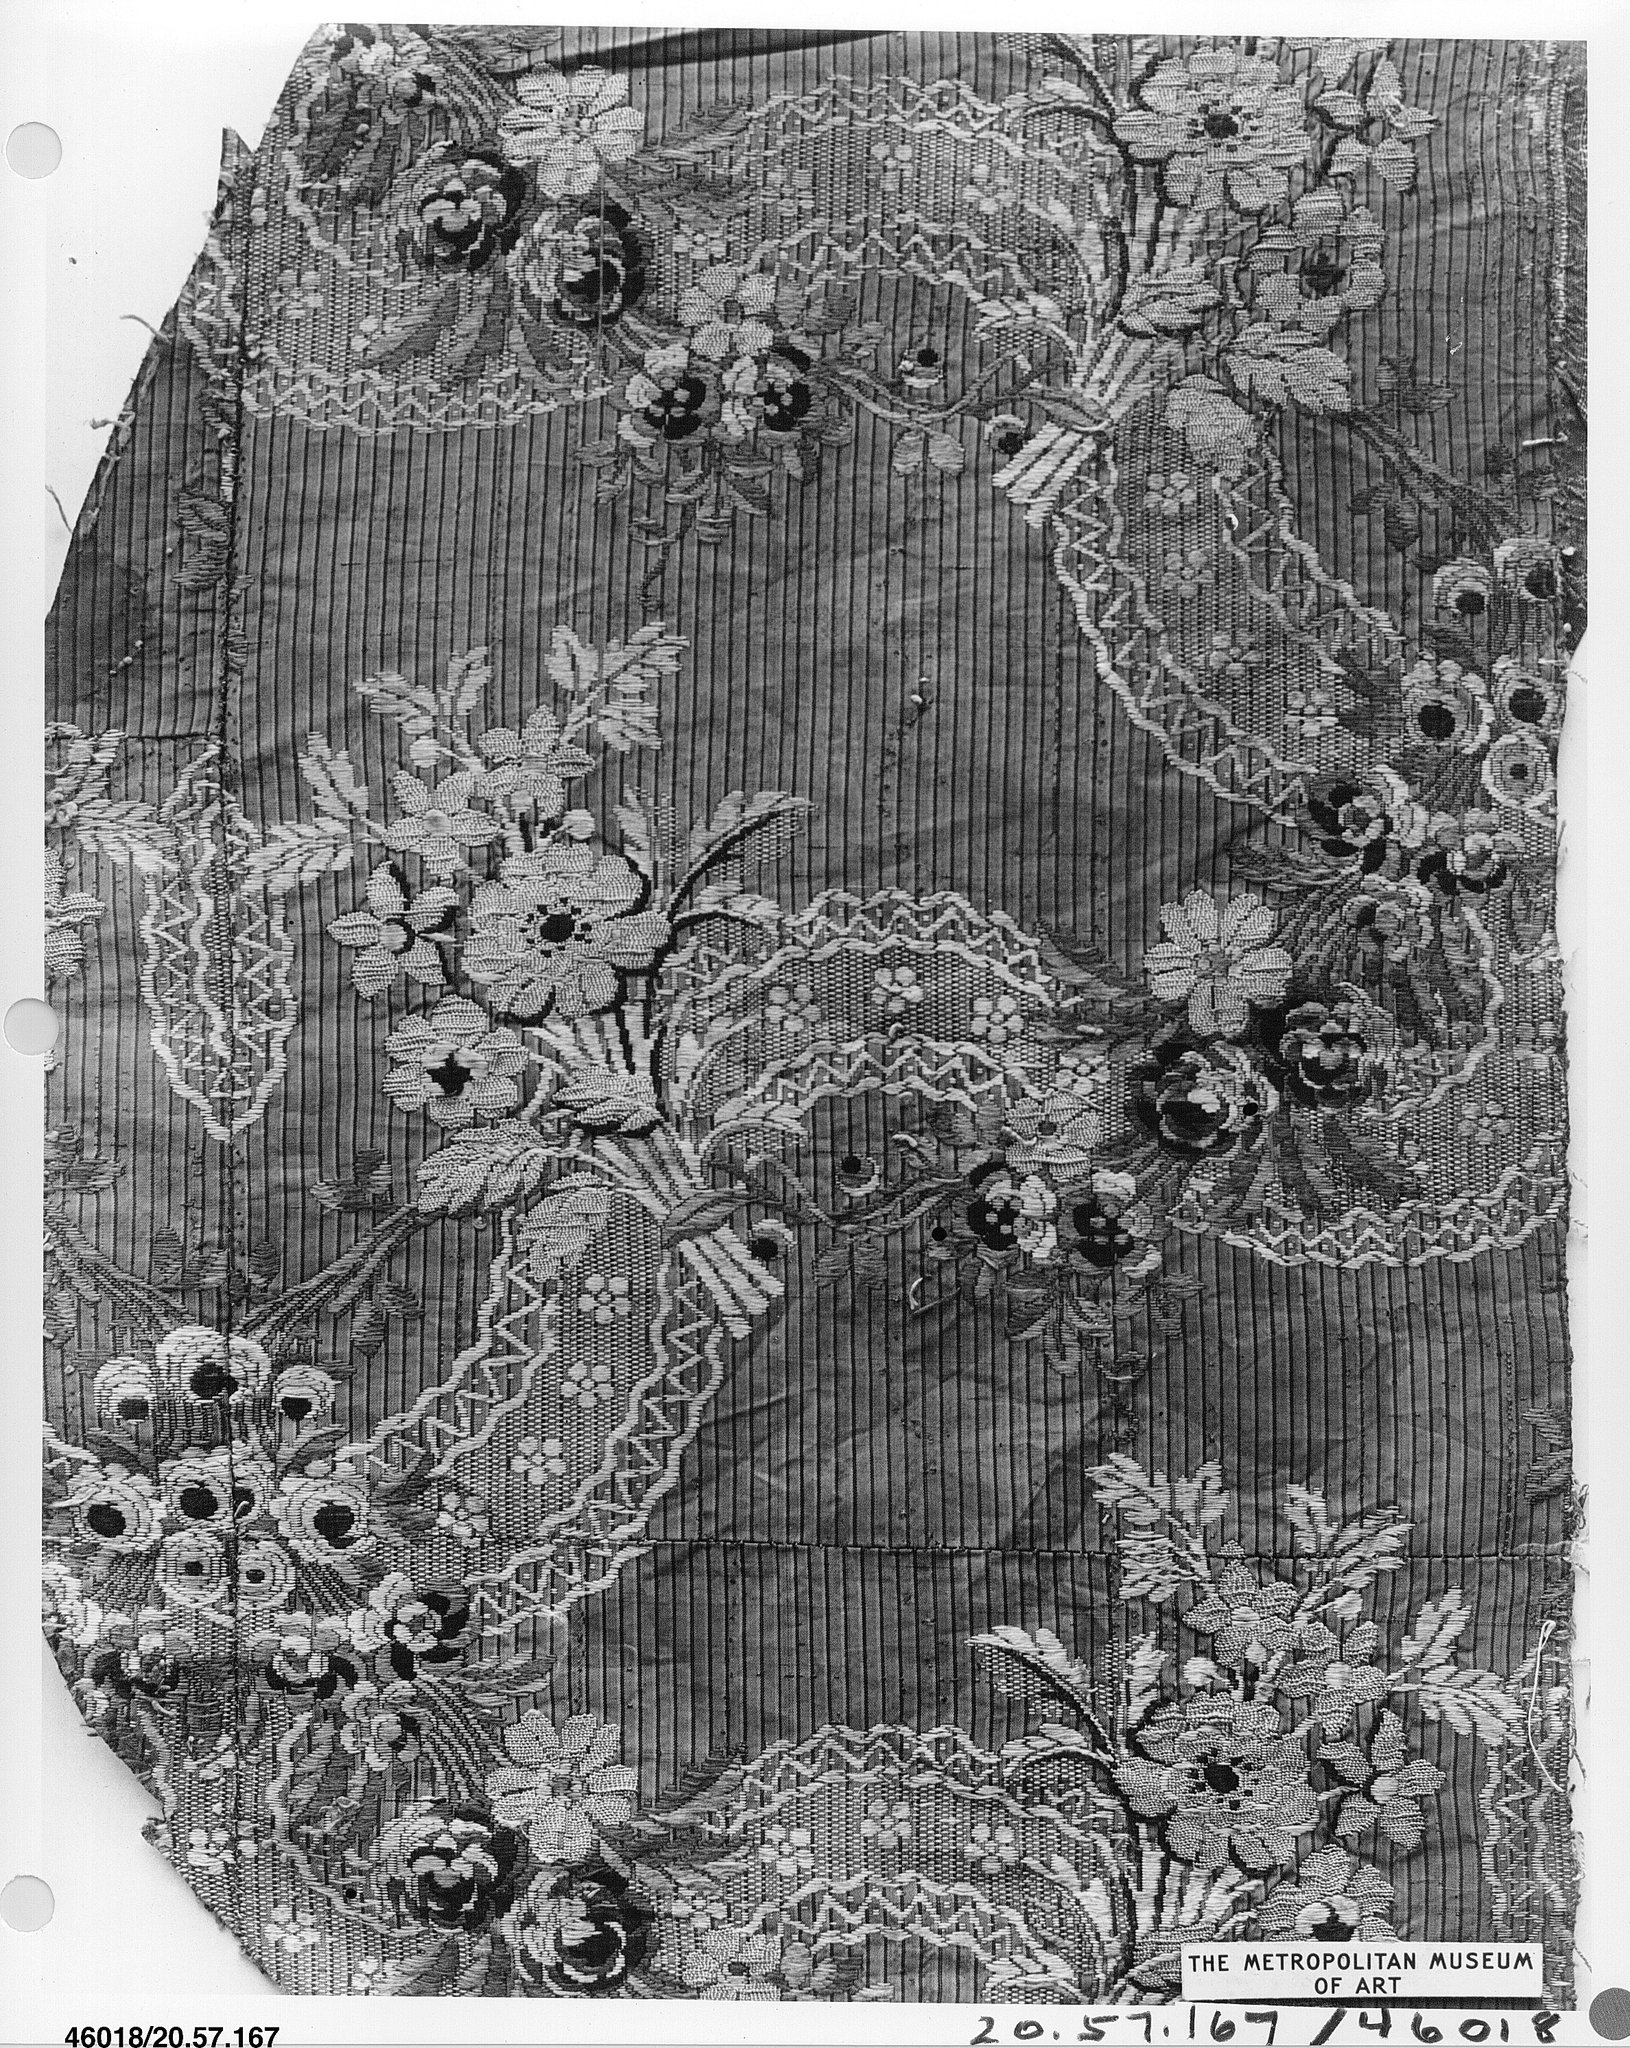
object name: piece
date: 1760-1770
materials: silk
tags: flowers,leaves